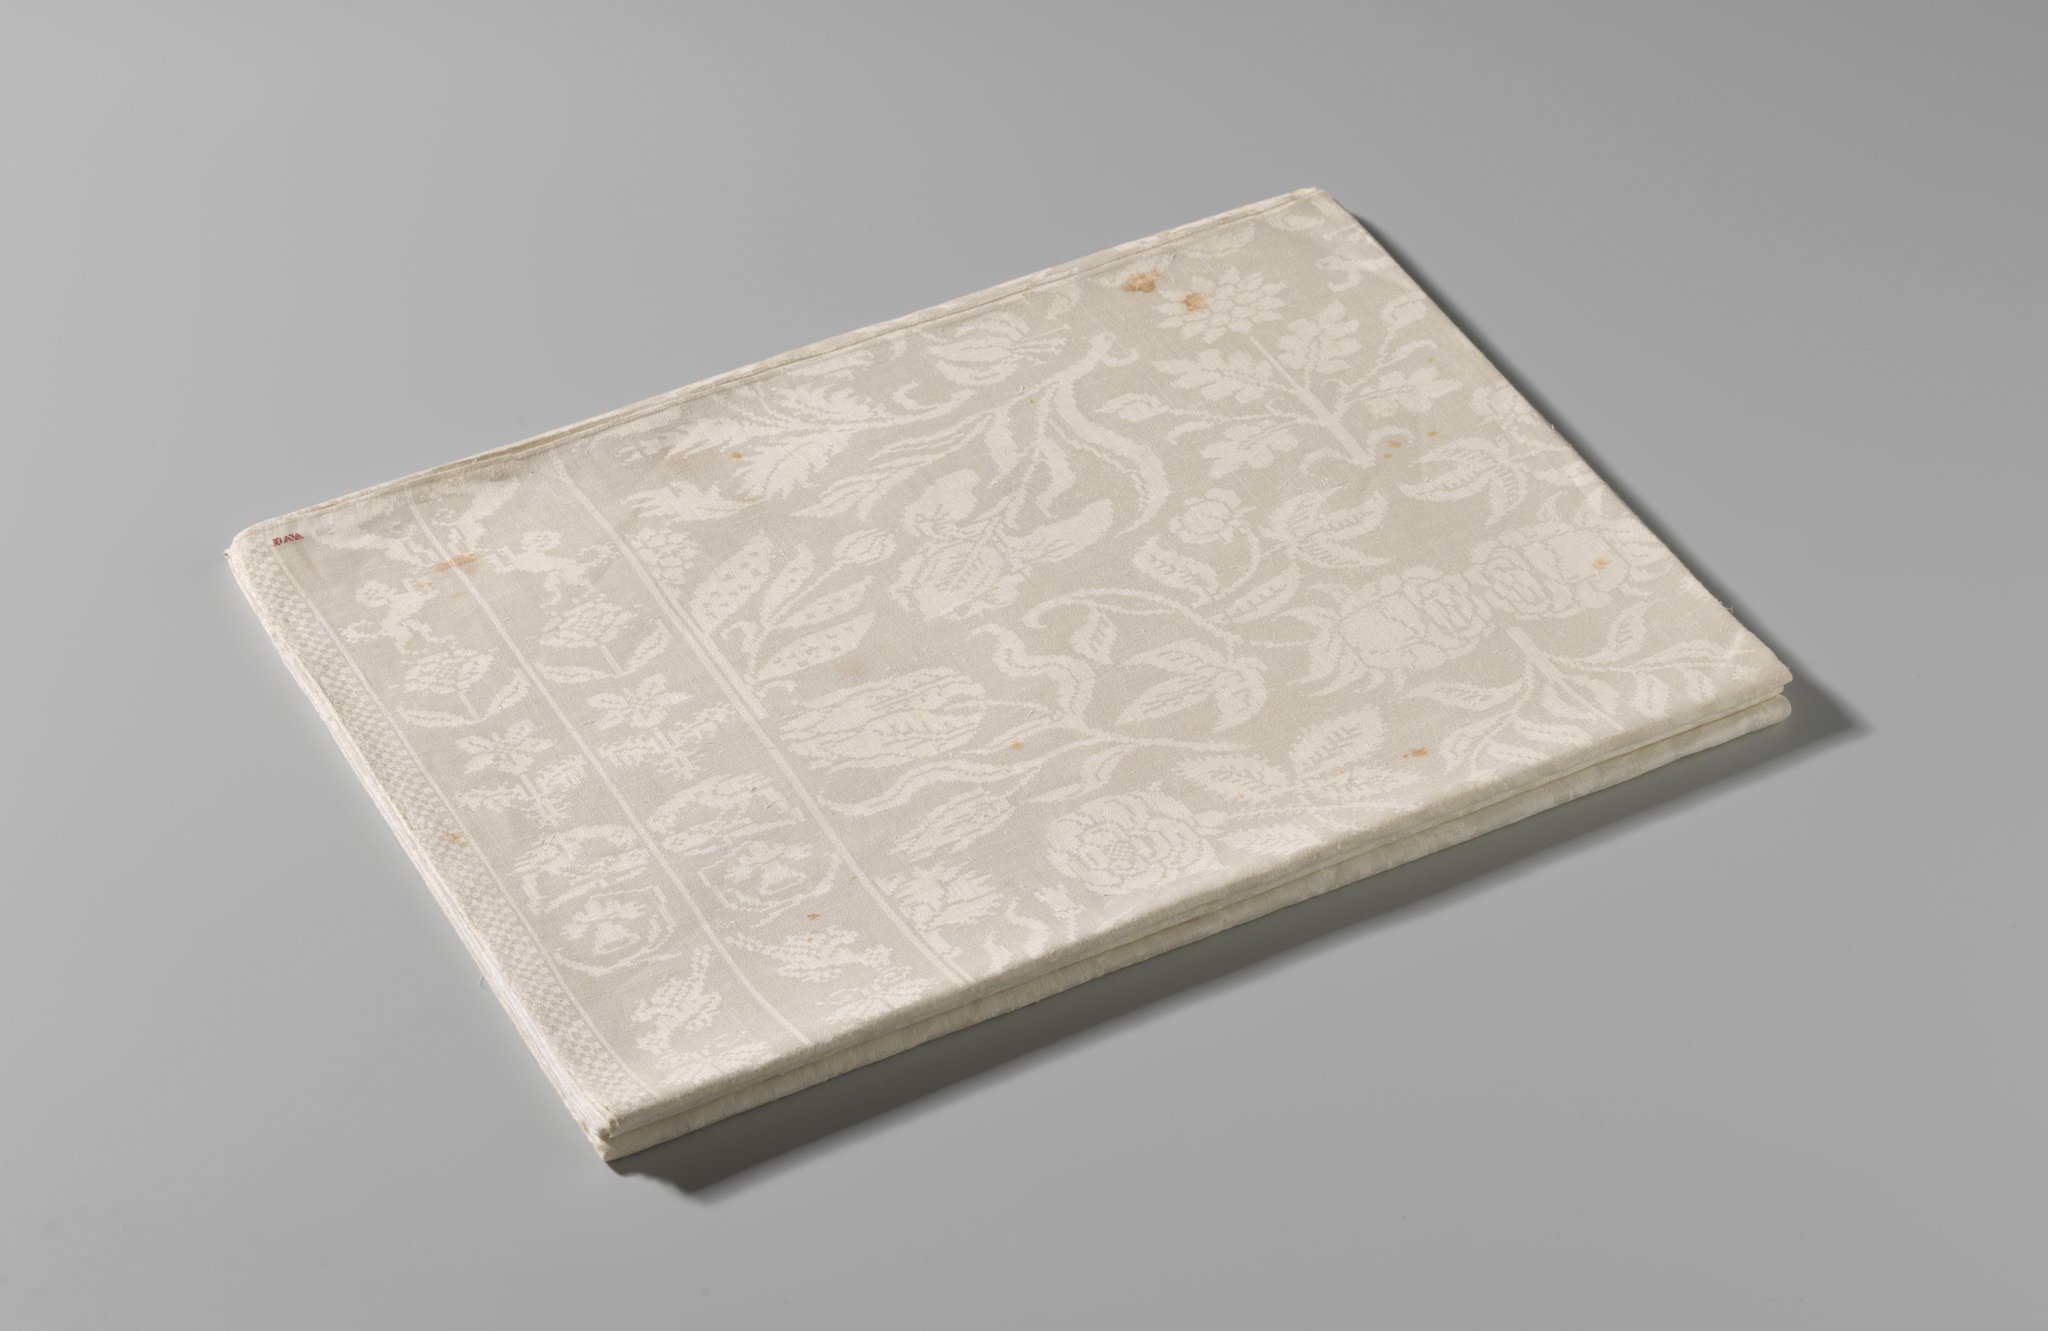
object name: tablecloth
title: Tafellaken met gestrooide bloemen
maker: Anonymous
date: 1650-1660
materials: linen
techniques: damask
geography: southern netherlands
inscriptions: mark: ‘2’, mark: ‘DAVA’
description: 16/4 Tafellaken van linnendamast, met een patroon van gestrooide bloemen aan bebladerde stengels. Lopende randen: bloemen, vogels en twee honden die een hert achtervolgen.